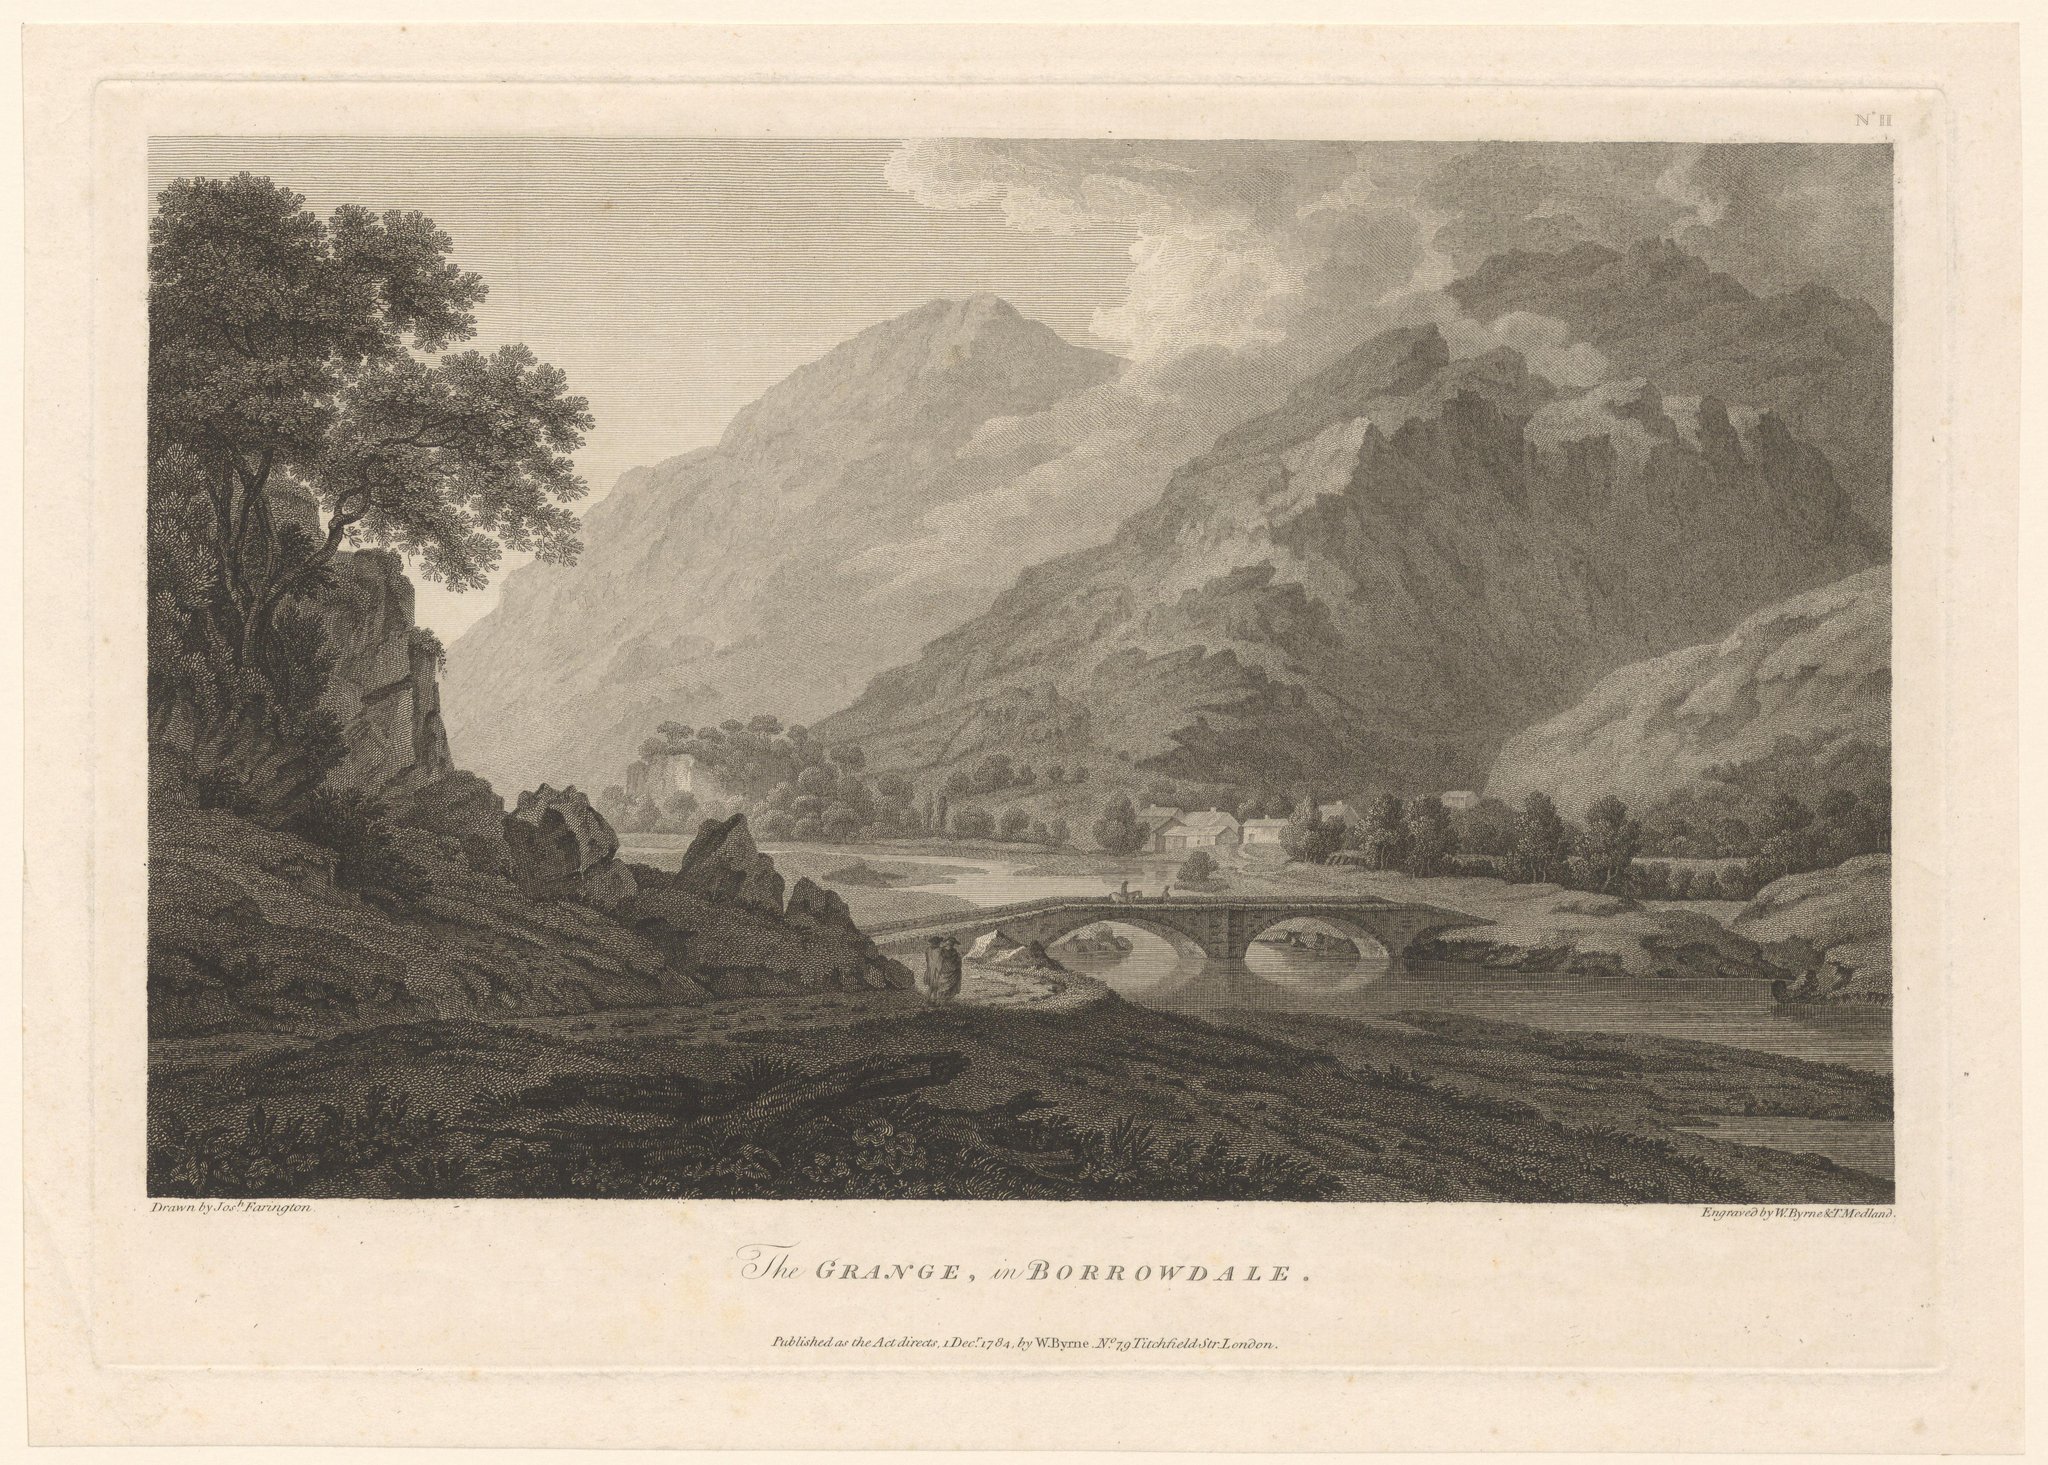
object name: print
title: The Grange, in Borrowdale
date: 1712-1784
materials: paper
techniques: etching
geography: london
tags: landscape with bridge, viaduct or aqueduct (+ city(-scape) with figures, staffage), mountains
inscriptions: collector's mark: Lugt 2228